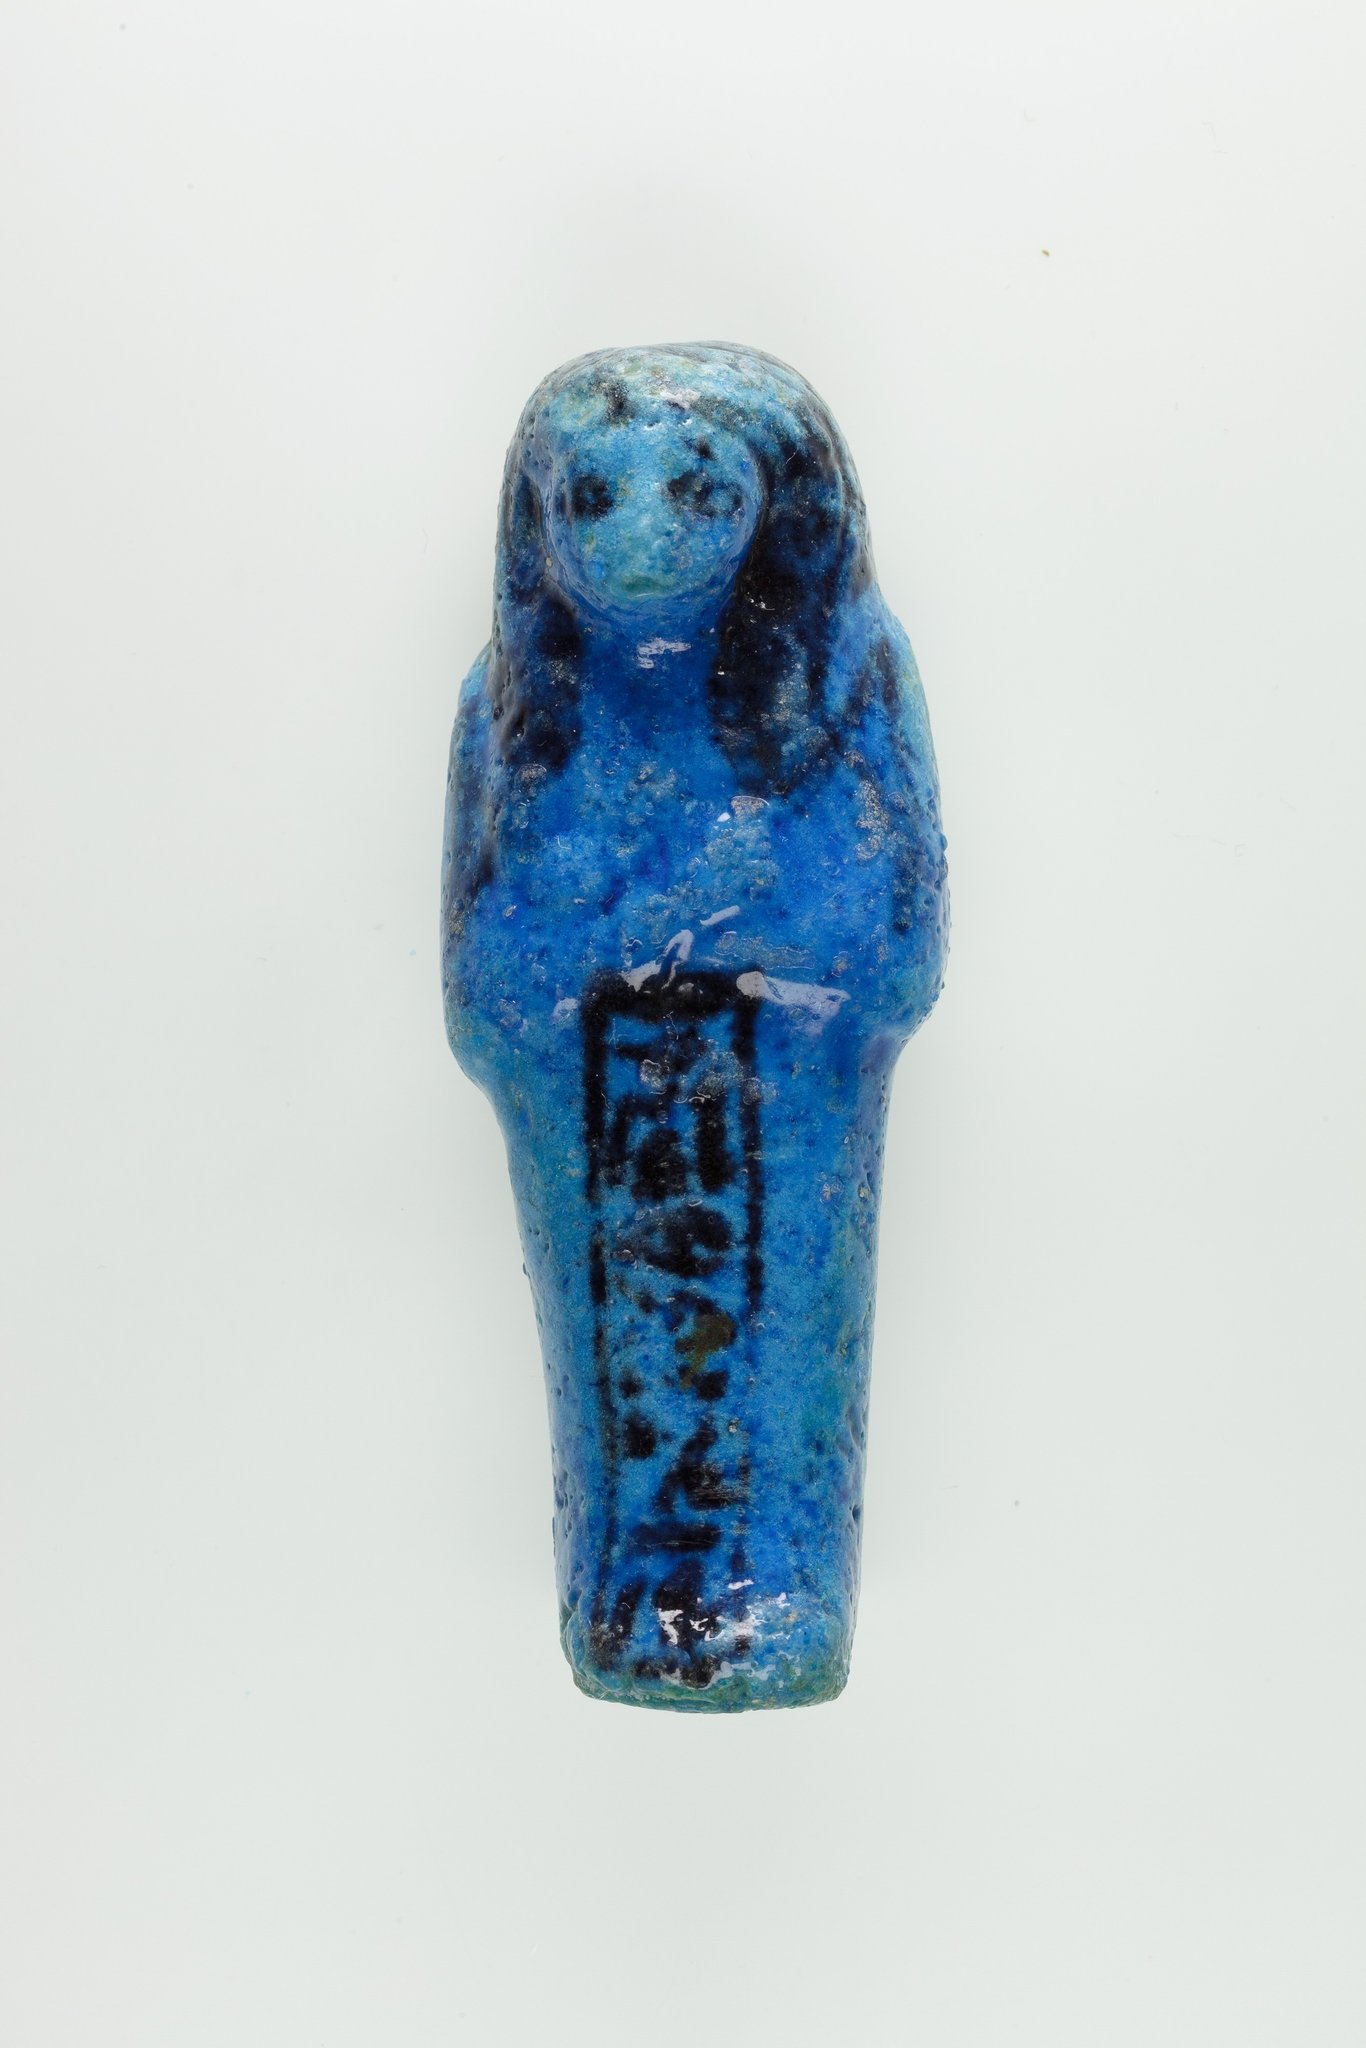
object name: shabti, worker, nauny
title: Worker Shabti of Nauny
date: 1050 BCE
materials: faience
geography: egypt